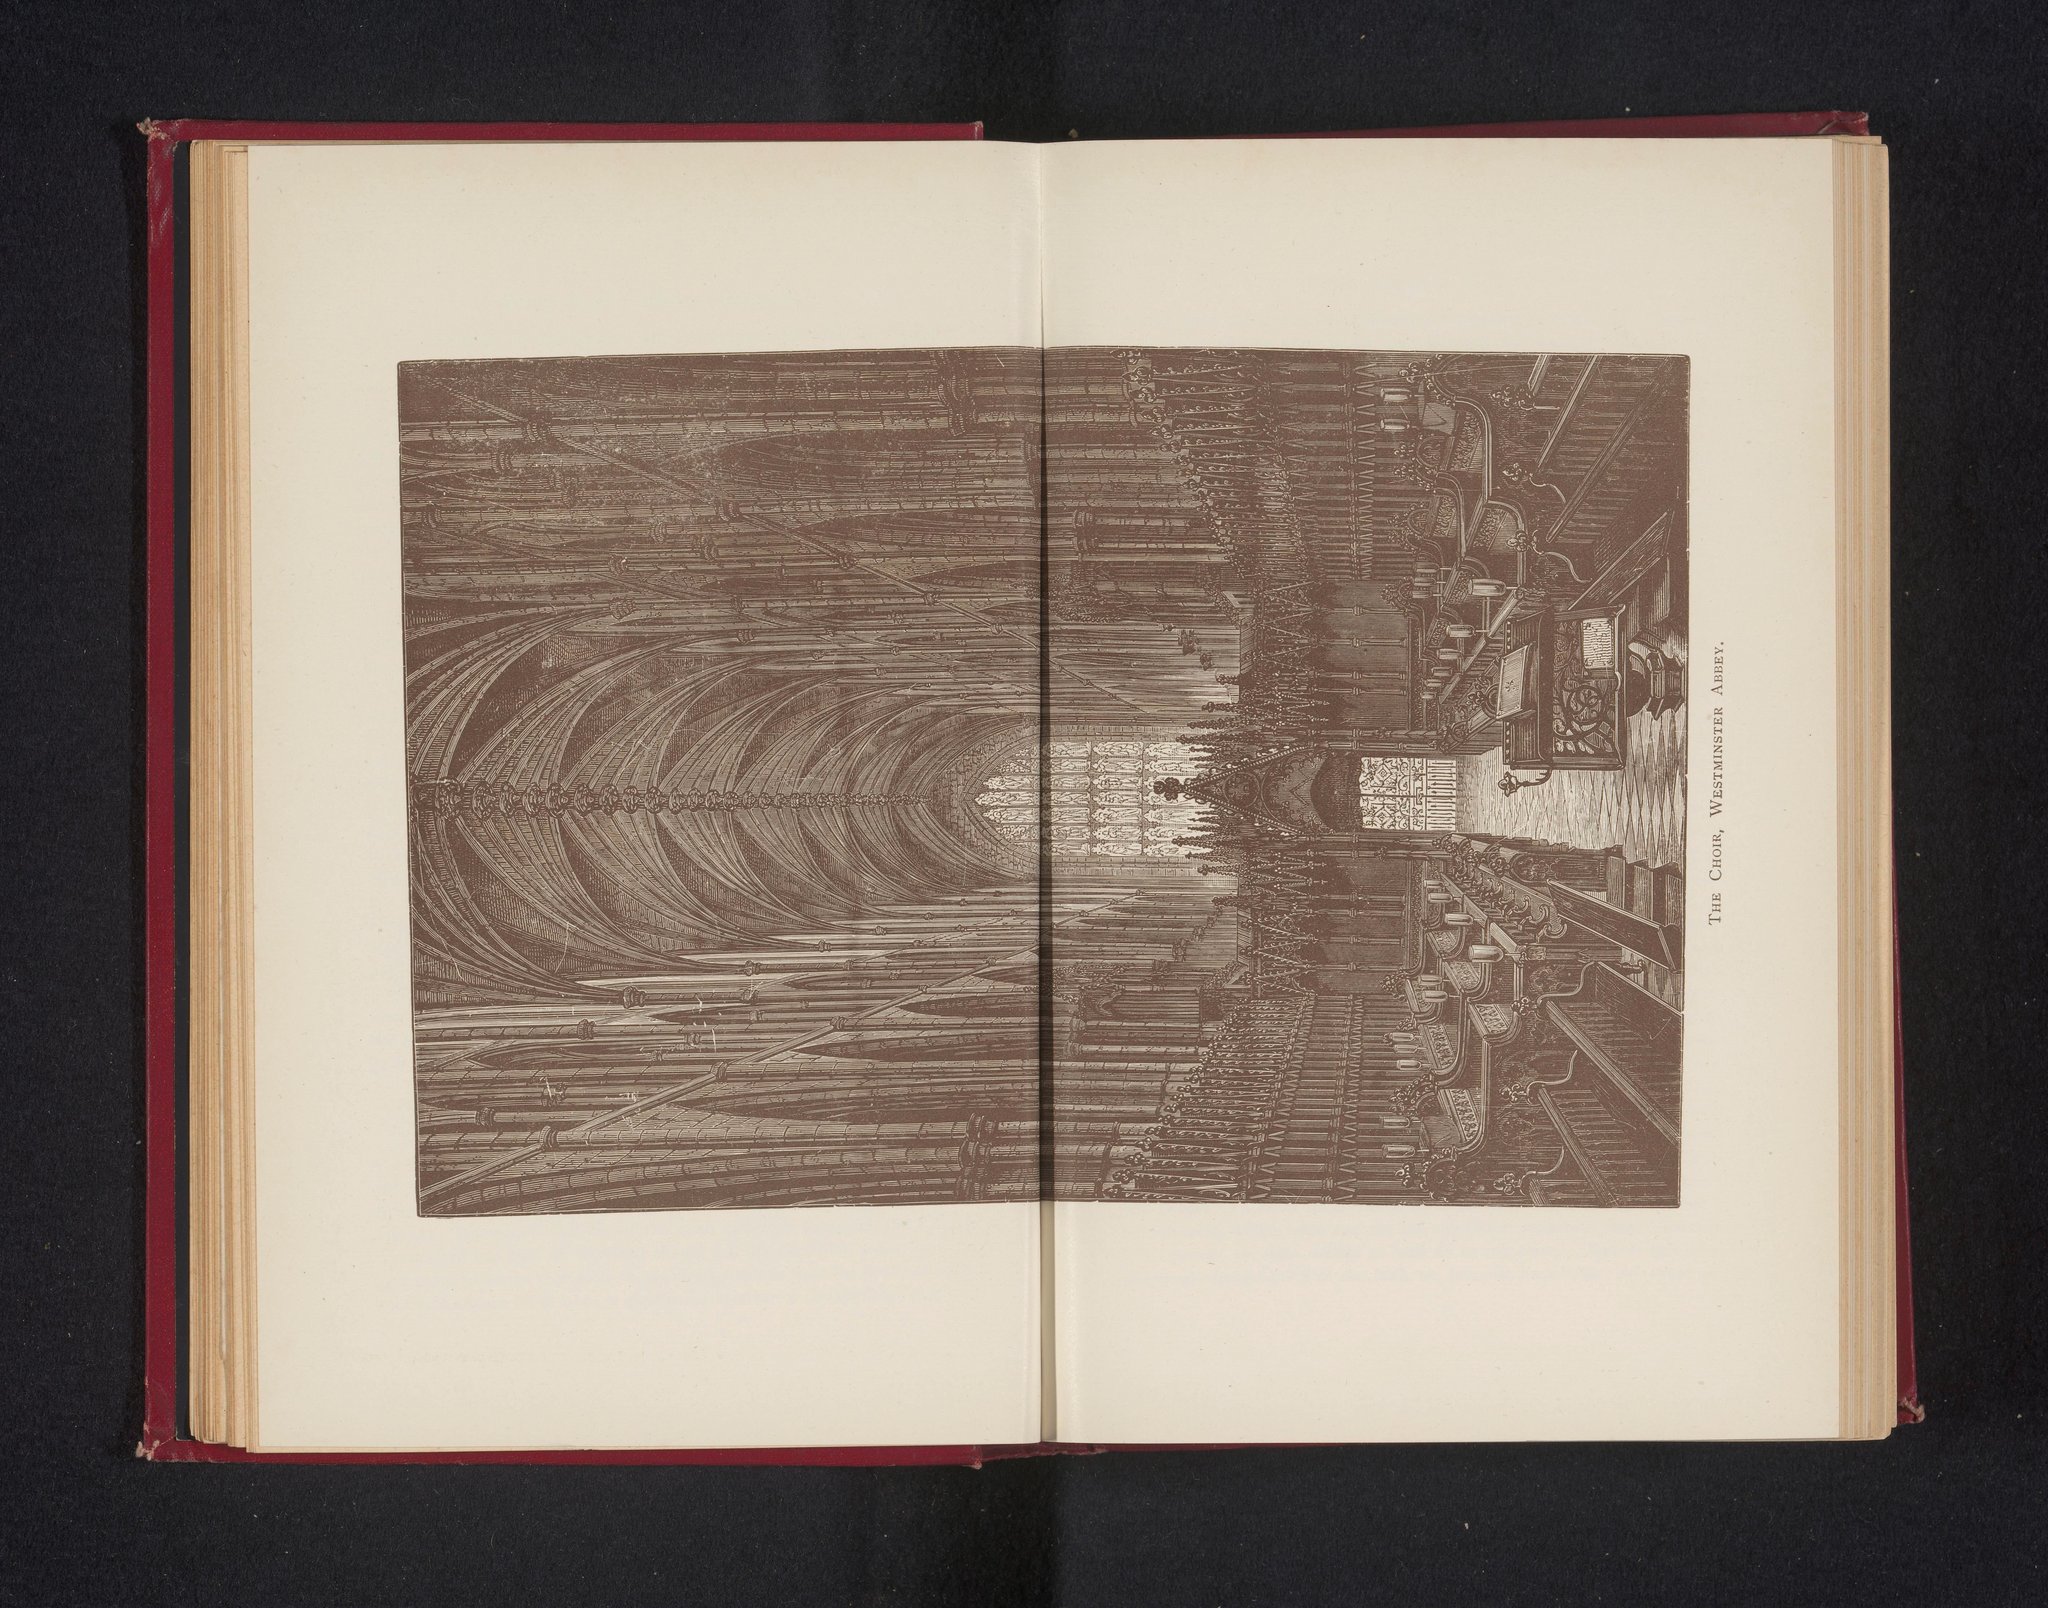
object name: reproduction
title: Reproductie van een foto van een portret van Frederick Temple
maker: Anonymous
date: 1890-1895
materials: paper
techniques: engraving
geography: london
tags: london, priest, historical persons